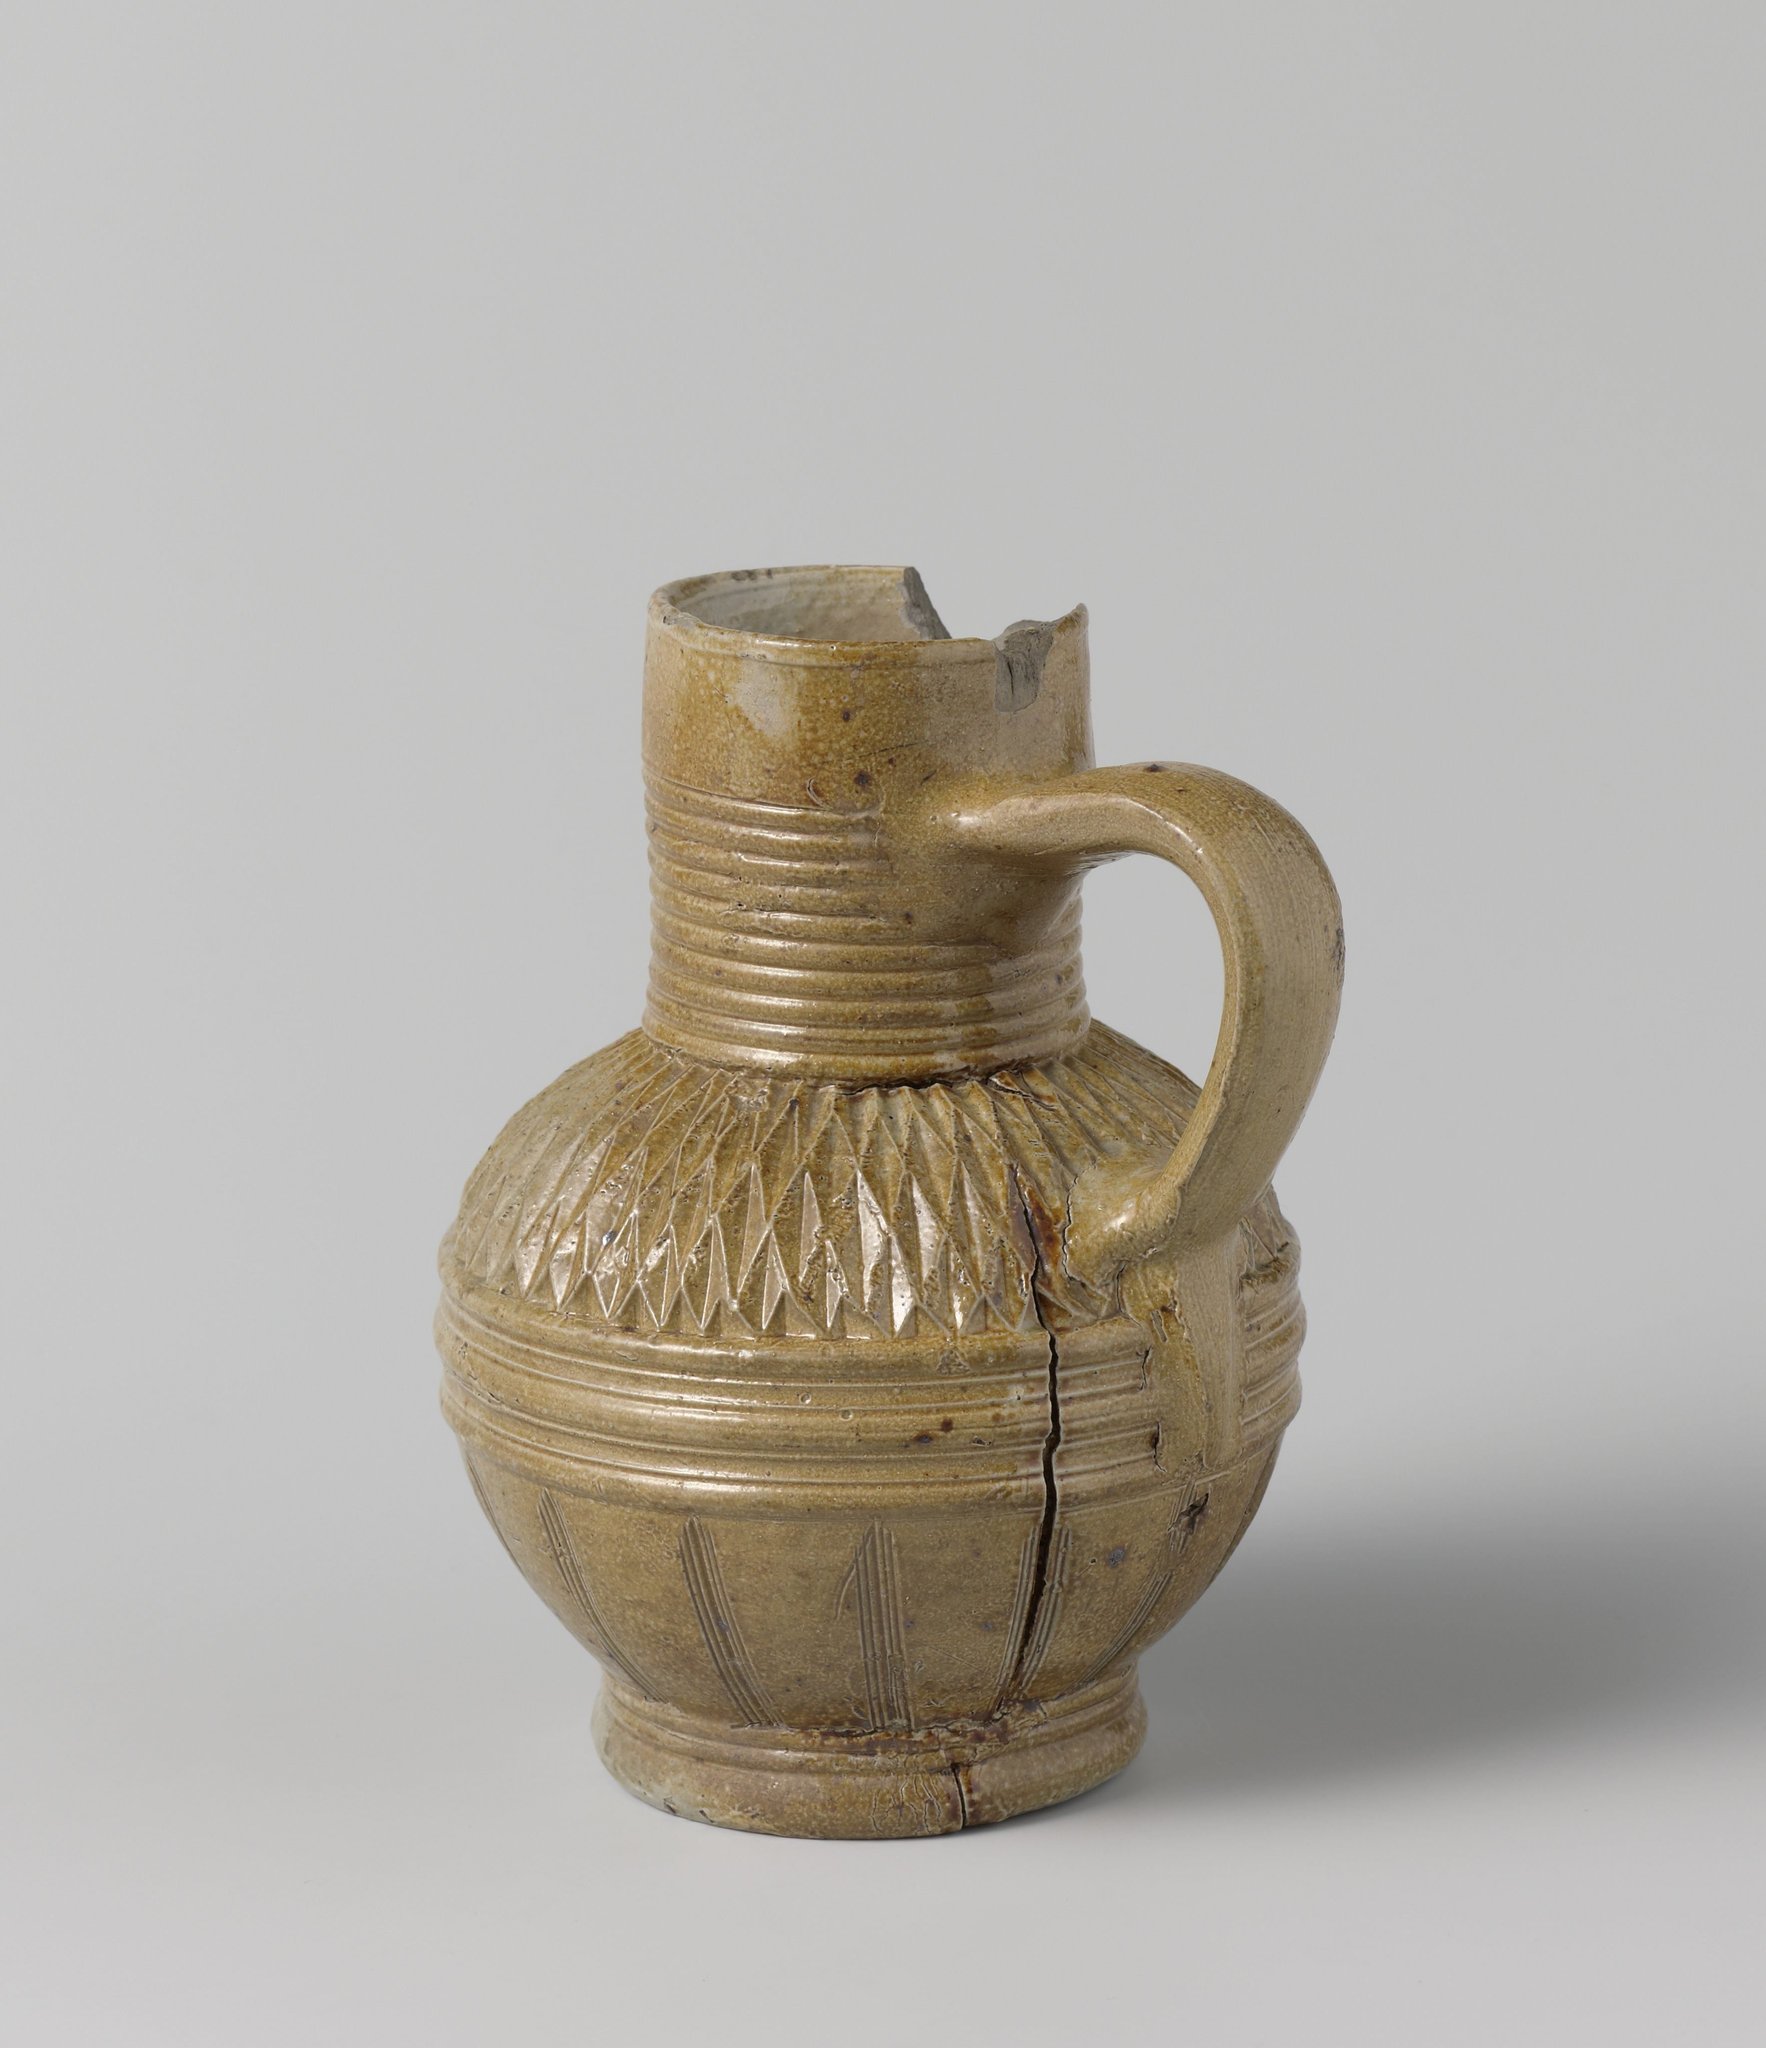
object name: jug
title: Jug with chip carving and incised borders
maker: Anonymous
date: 1550-1620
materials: engobe, glaze, stoneware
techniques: firing, forming, turning, vitrification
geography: raeren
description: Kruik van steengoed op standring met een bolvormig lichaam en wijde nek. Het C-vormige oor is bevestigd aan de nek en de schouder. Geribde nek en profielen op de voet en buik. Bedekt met een bruine engobe. Het onderste deel van de buik met verticale, ingegrifte banden. Op de schouder een band met kerfsnede. Raeren.